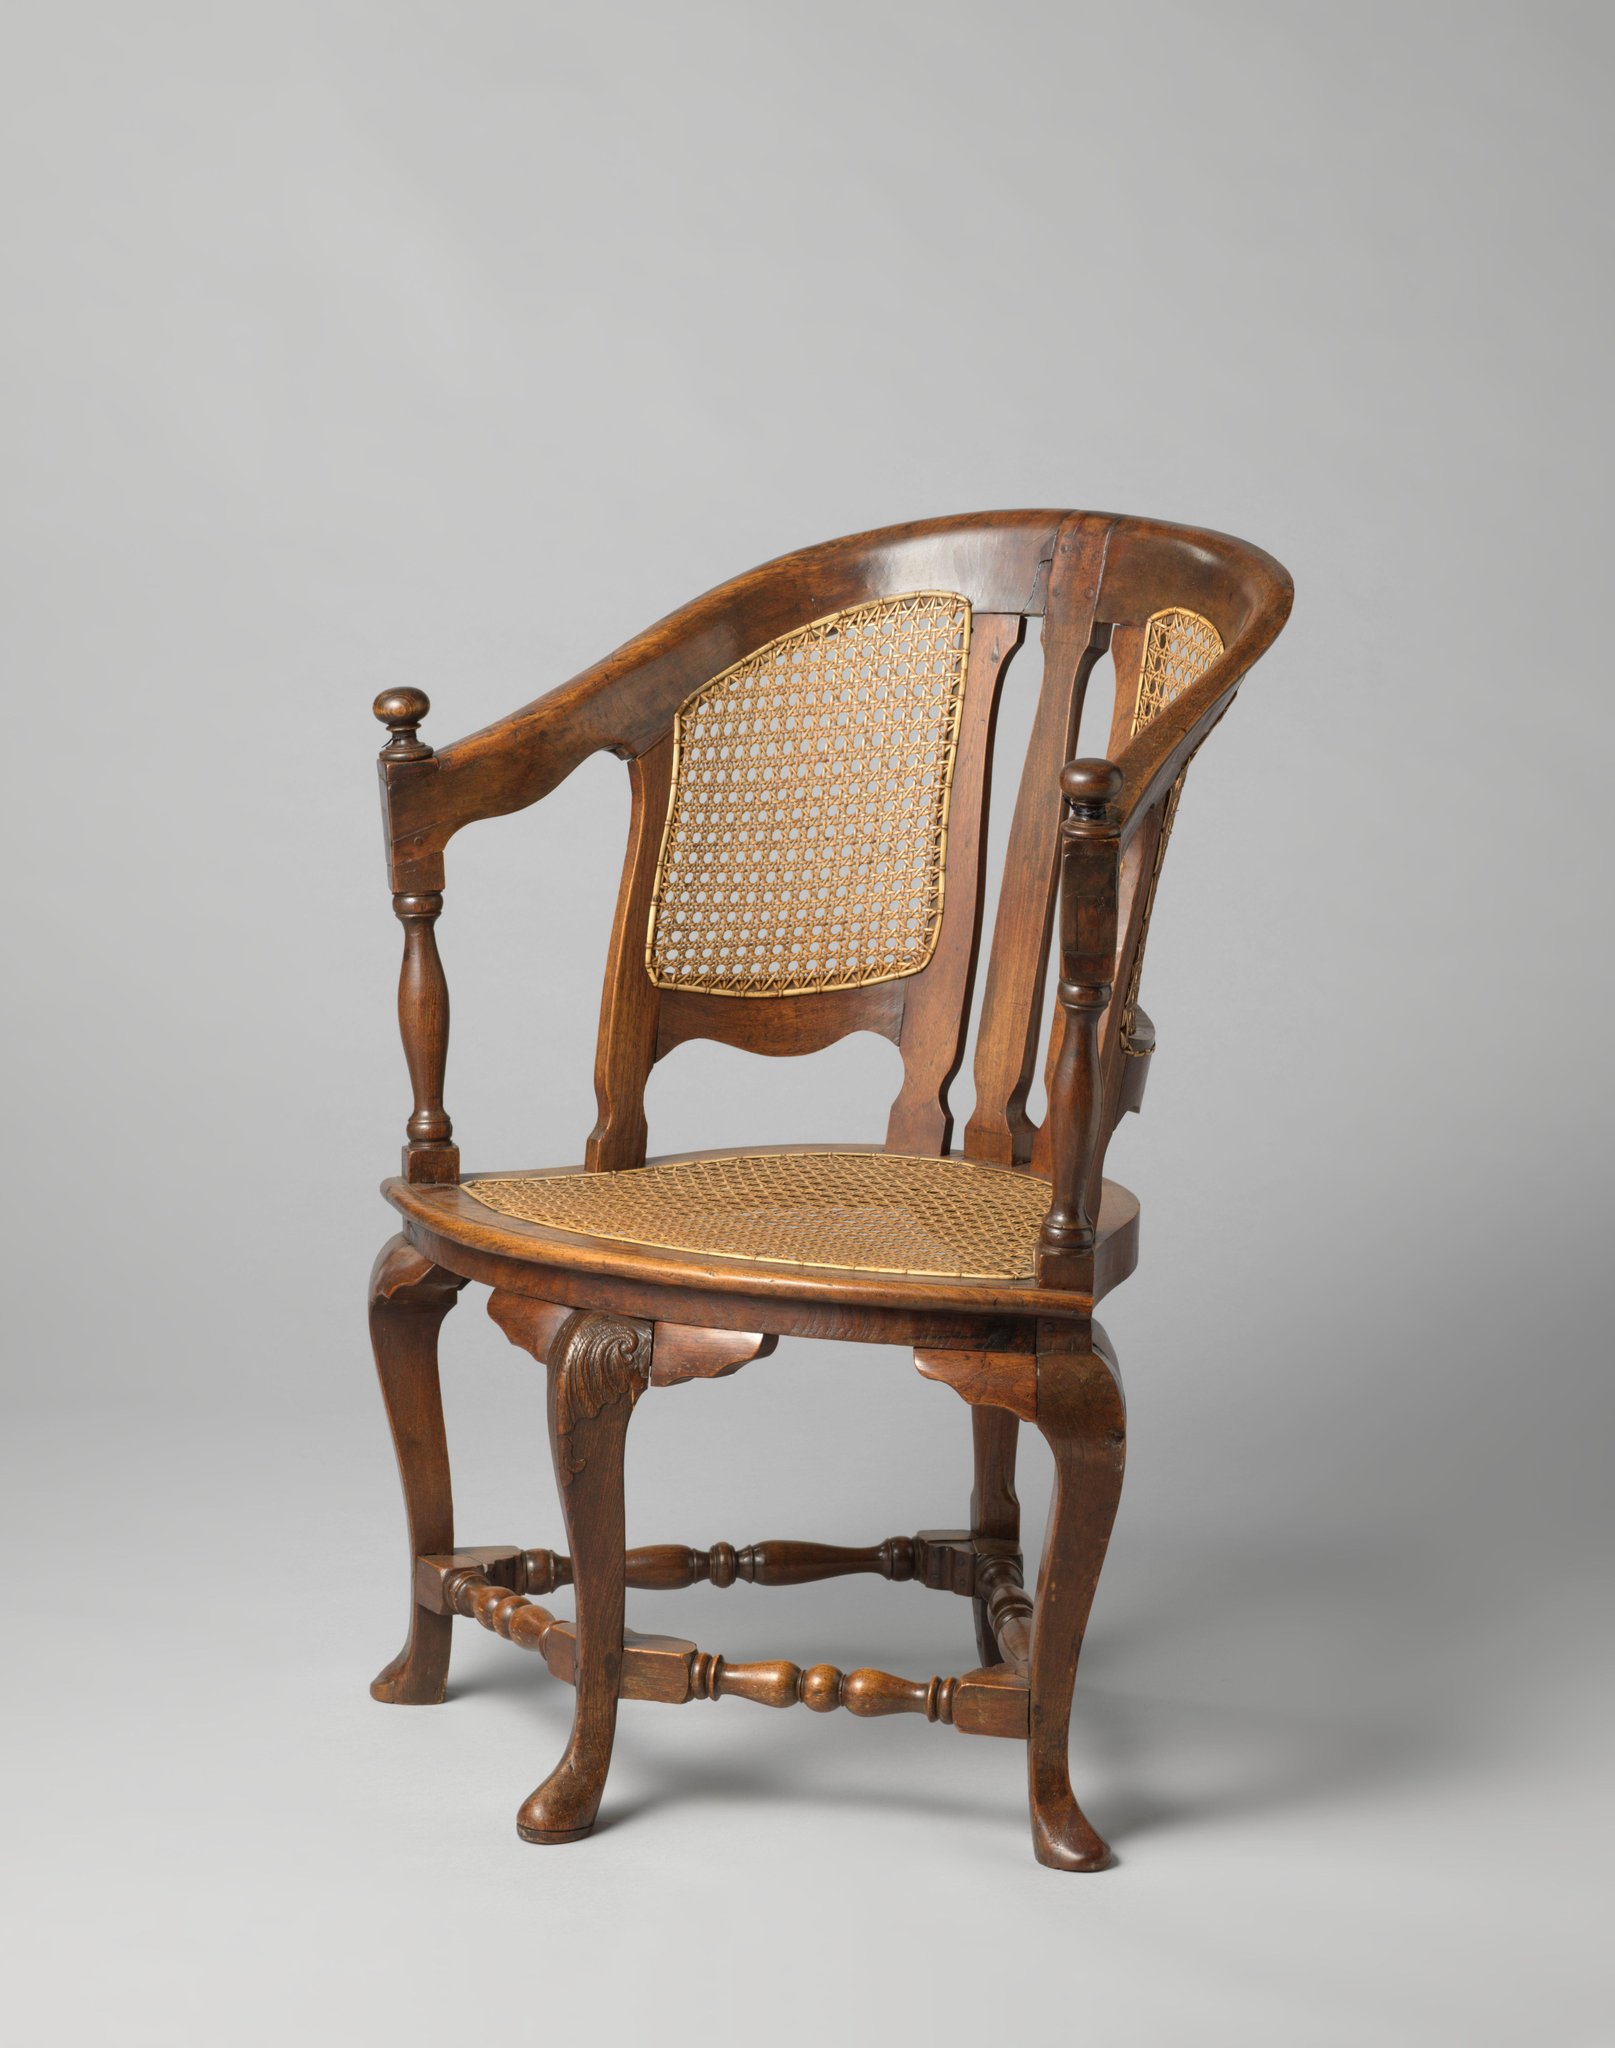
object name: seating furniture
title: Armstoel op driehoekig grondplan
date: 1700-1725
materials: rattan, wood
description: Chair. Teak, cane. Indonesia, c. 1700 - 1725.